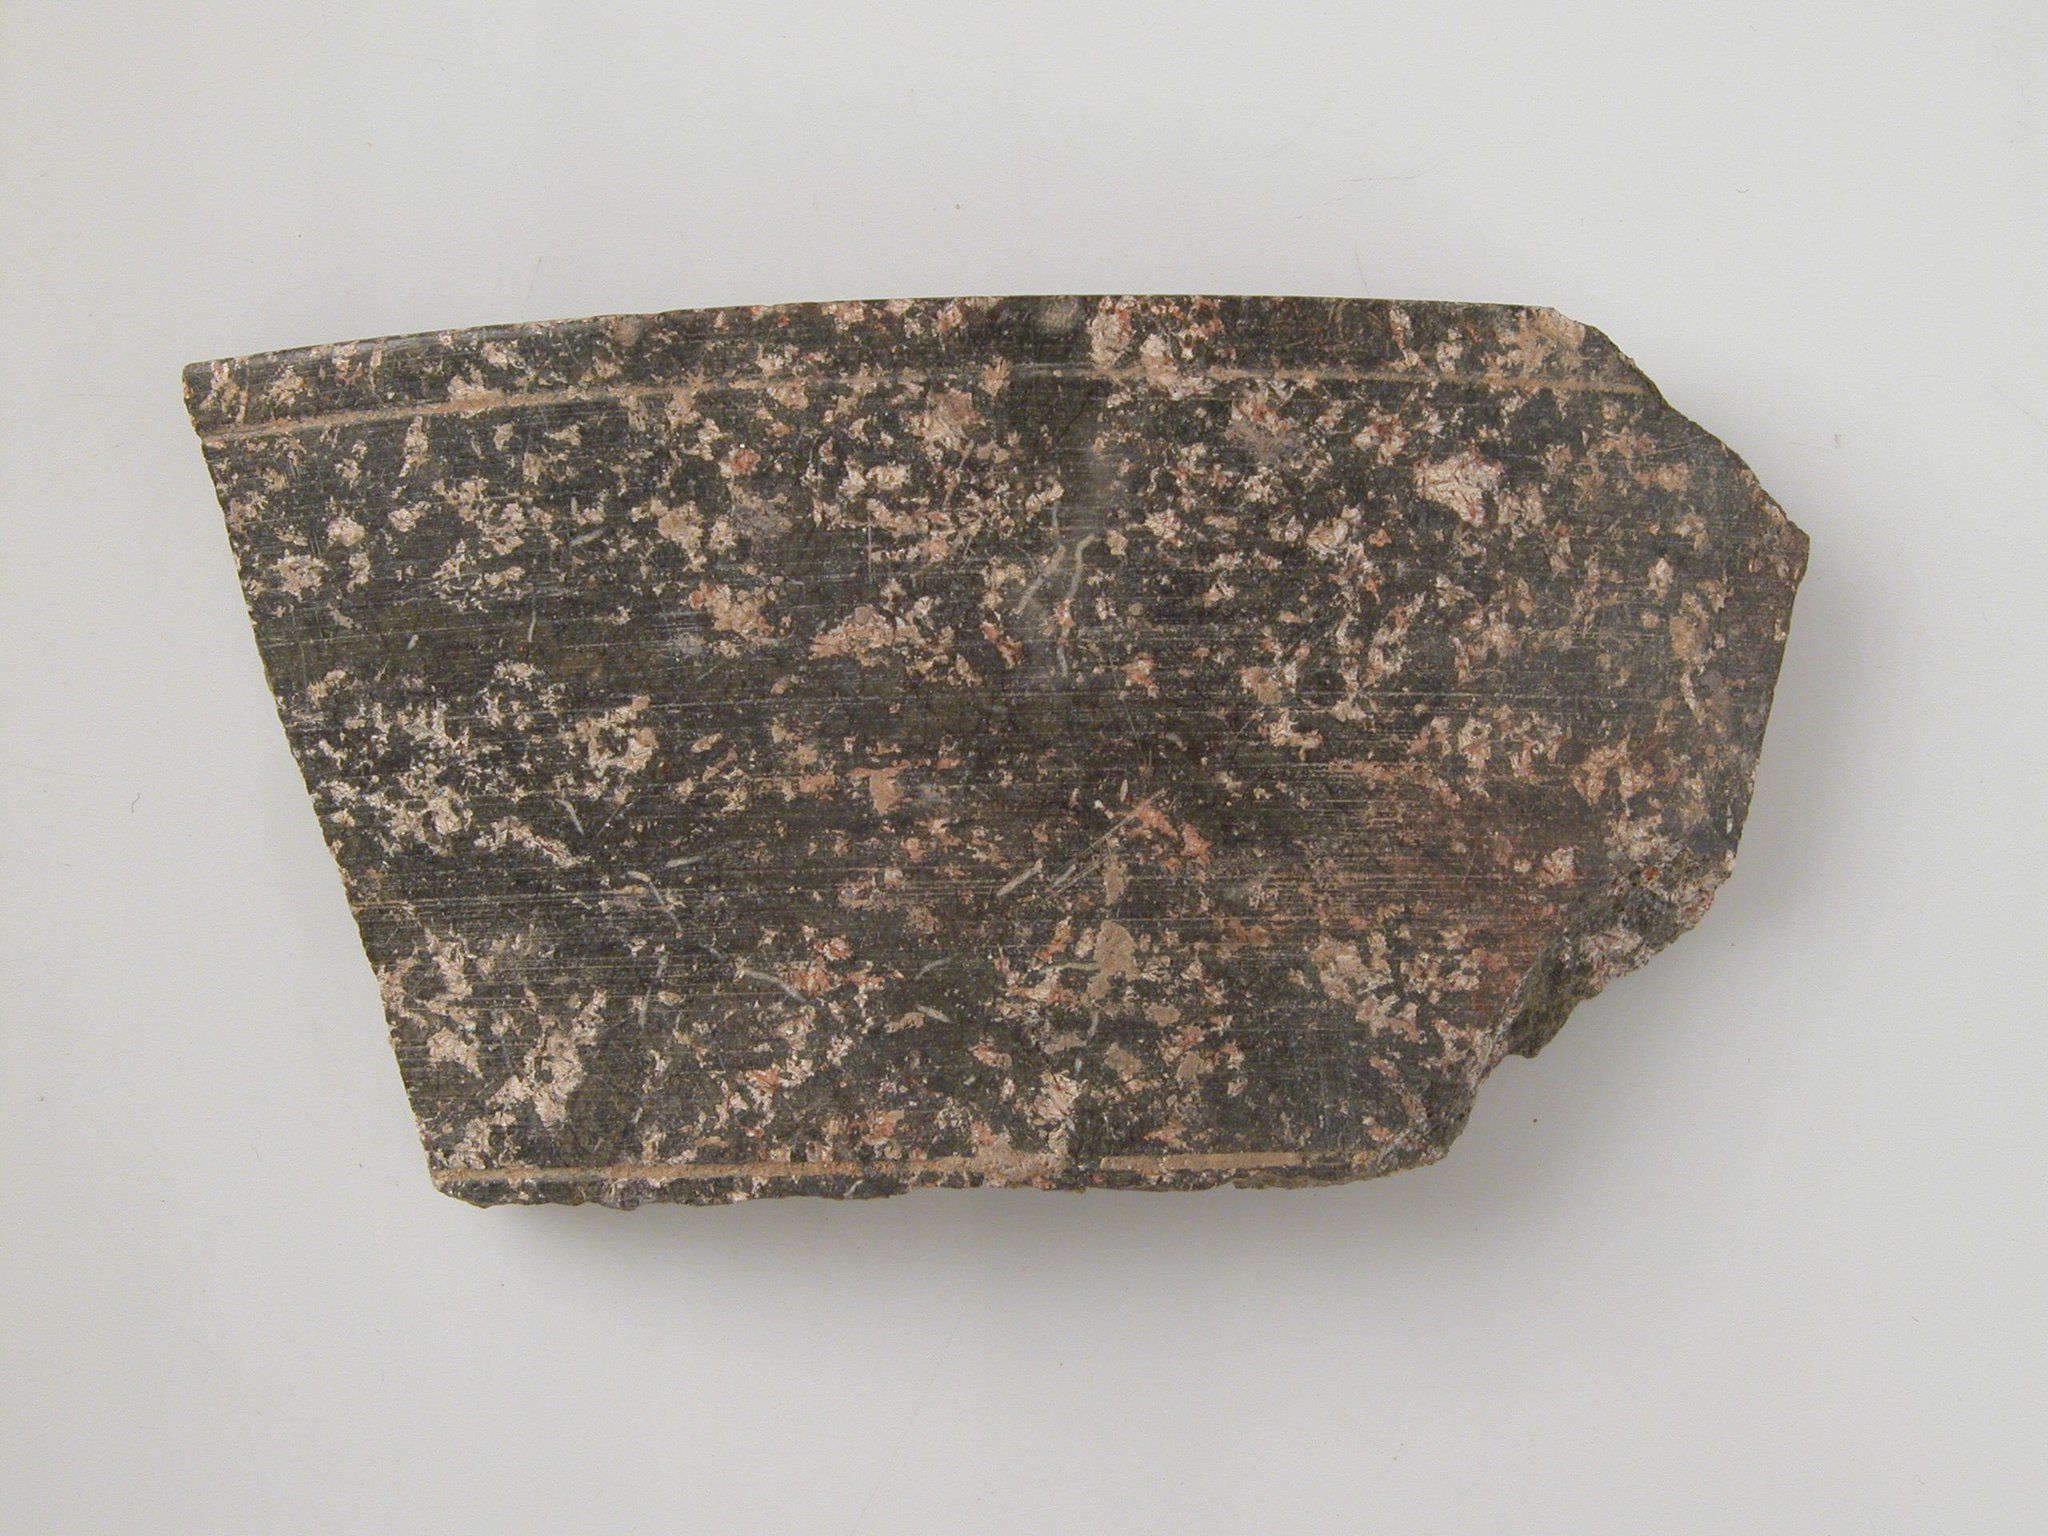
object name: stone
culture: coptic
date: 301-700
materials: stone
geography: egypt